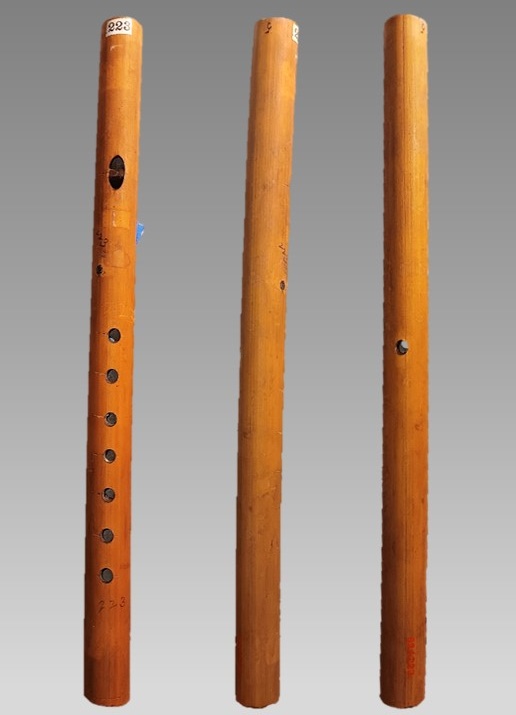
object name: palwei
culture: burmese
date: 1867-1900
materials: bamboo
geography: myanmar